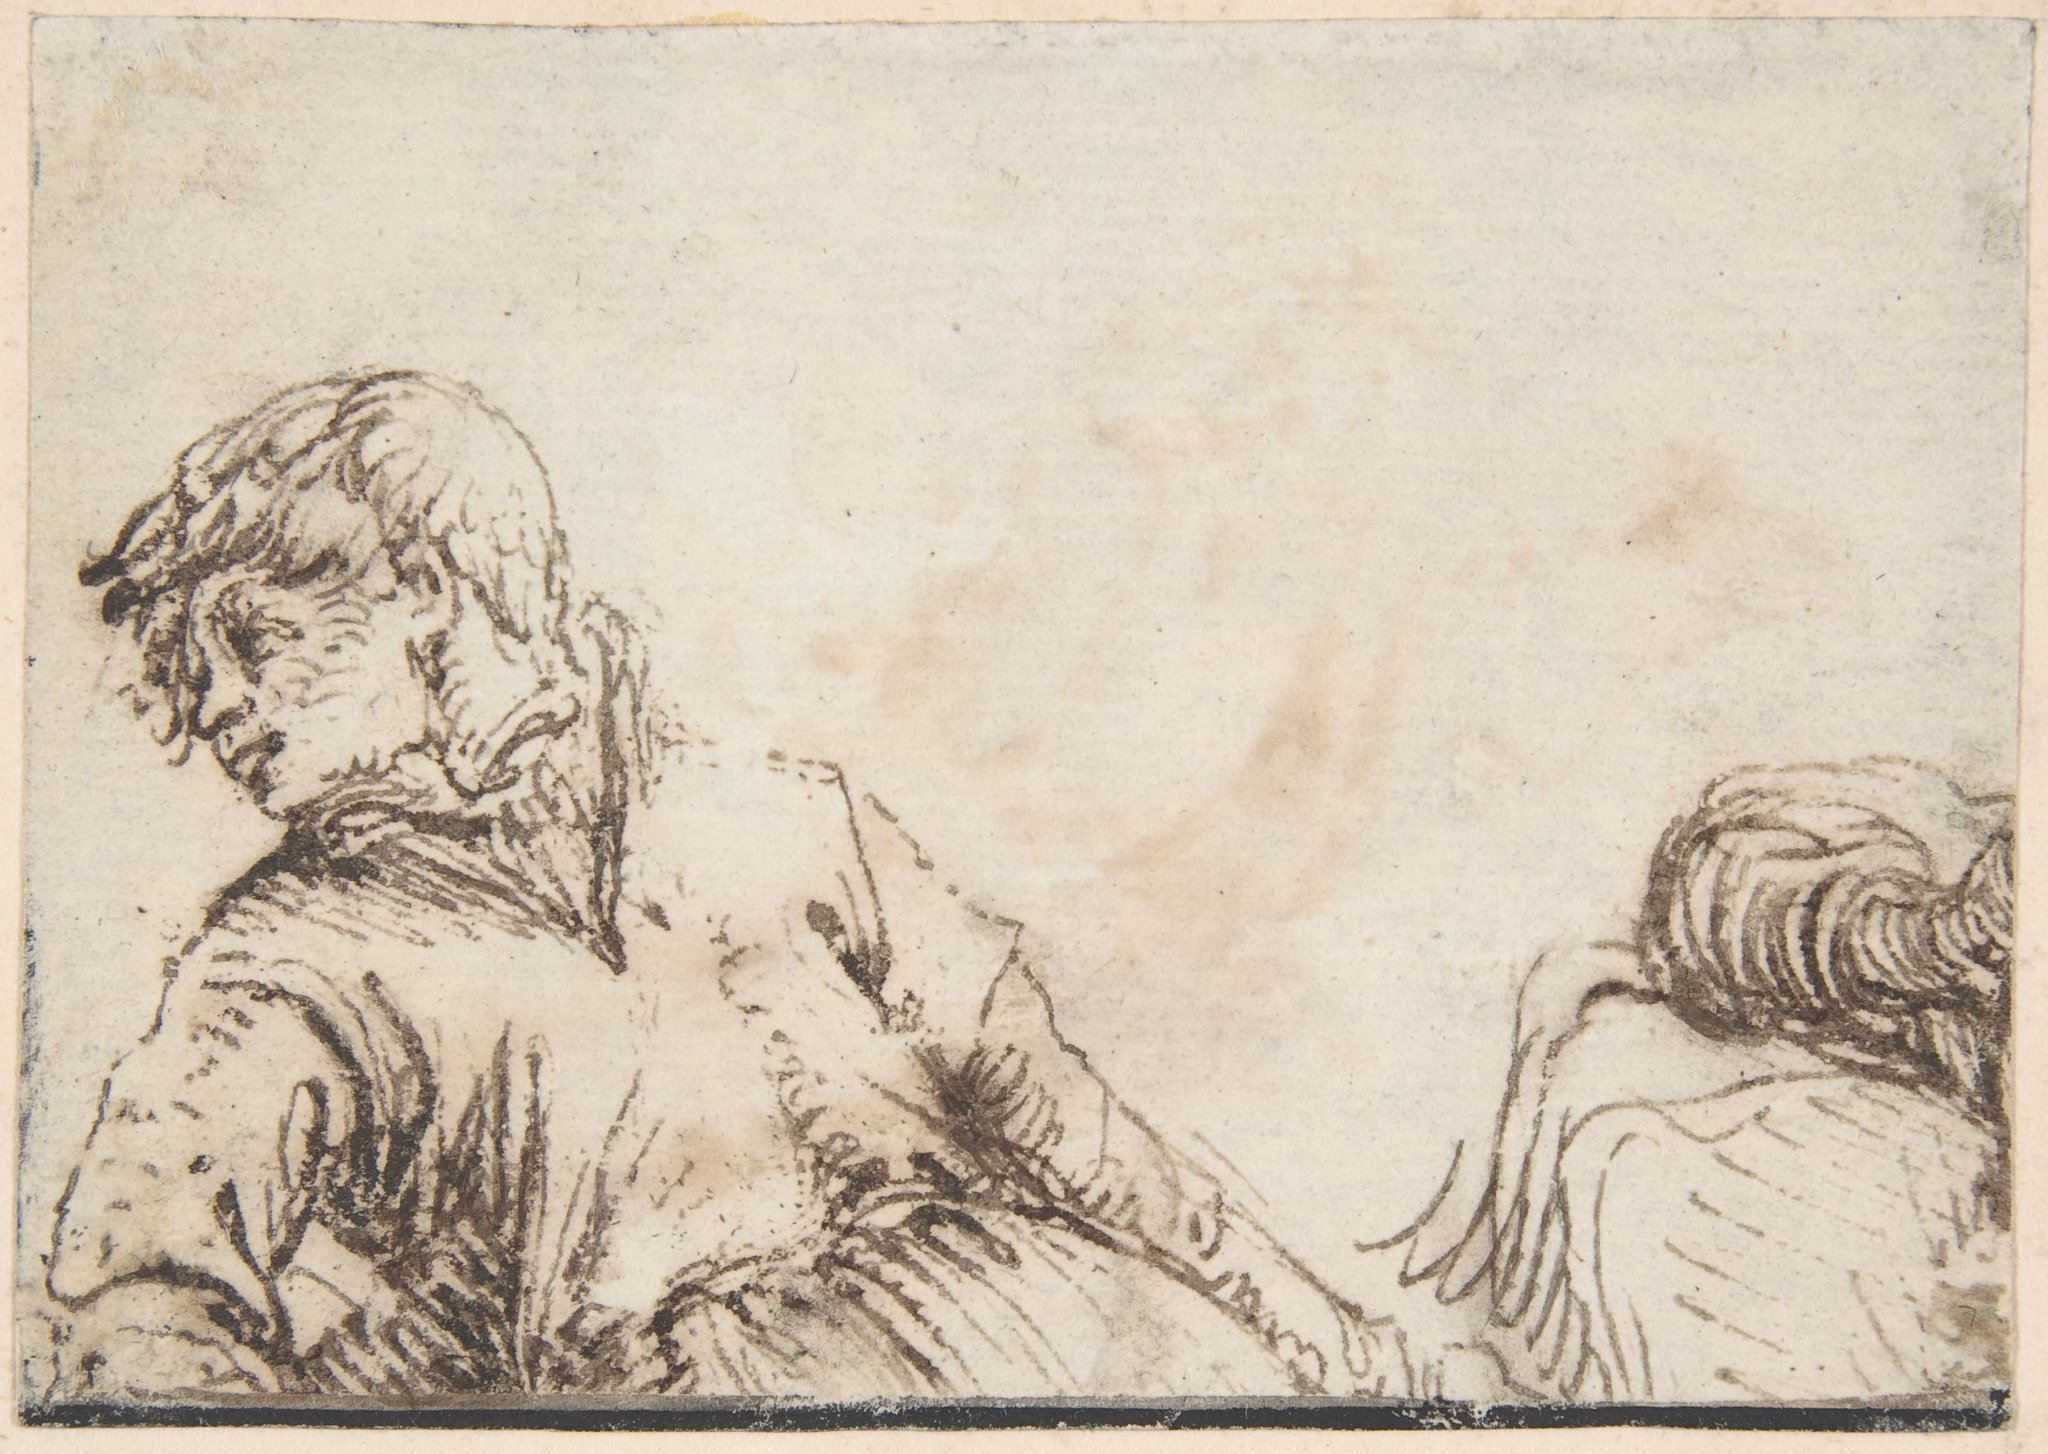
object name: drawing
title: Study of a Youth with his Head Turned to the Left and Leaning on his Right Elbow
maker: jacques de gheyn (ii)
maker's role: artist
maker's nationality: netherlandish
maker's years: 1565-1629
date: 1567-1633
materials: ink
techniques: pen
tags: men